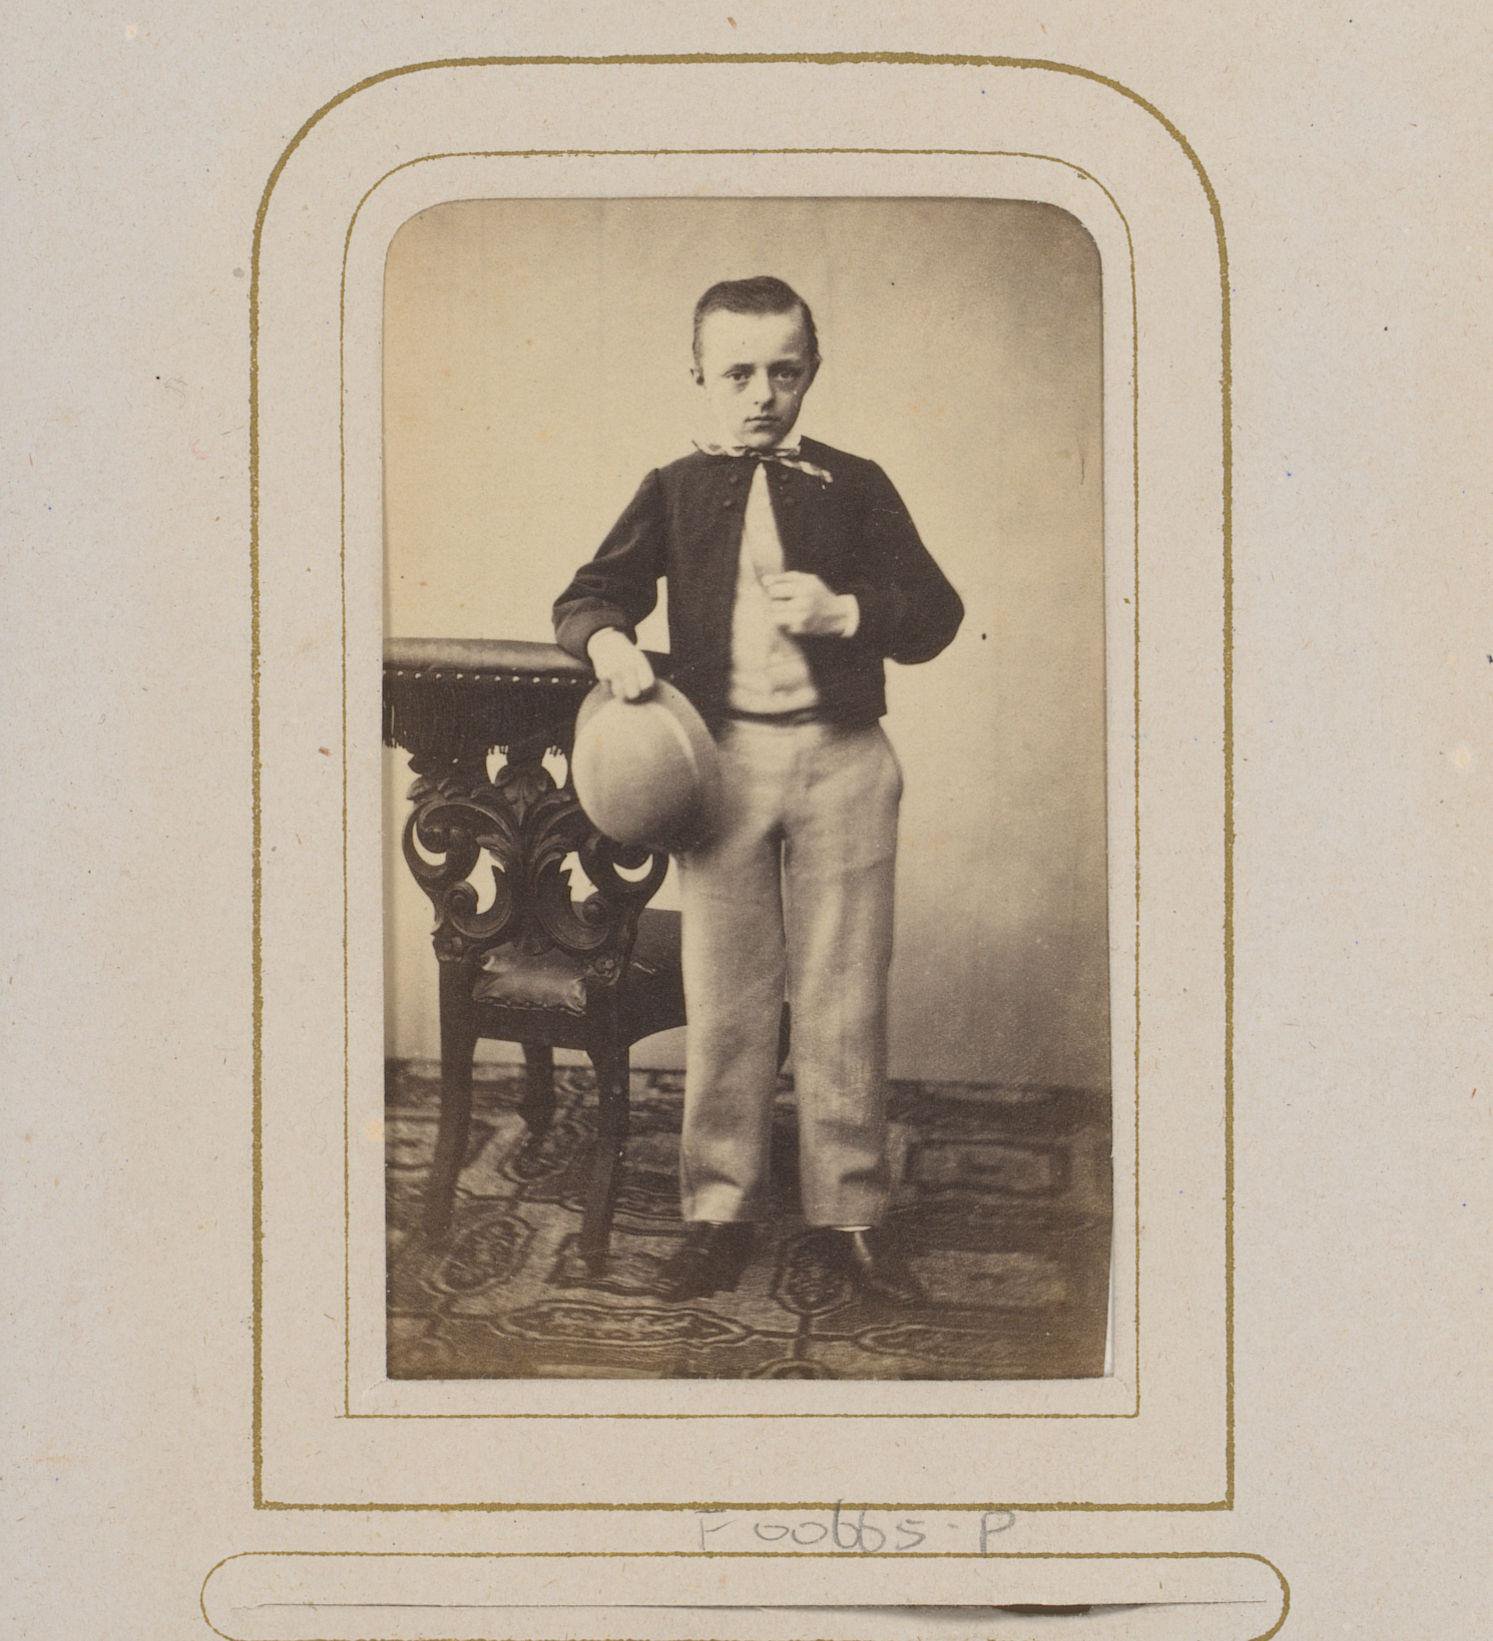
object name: photograph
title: Portret van een jongen met bolhoed in hand bij een stoel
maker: hermanus siderius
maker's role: draughtsman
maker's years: 1819-1892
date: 1855-1892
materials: cardboard, photographic support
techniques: albumen print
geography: harlingen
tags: boy (child between toddler and youth)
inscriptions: inscription: ‘H. Siderius/ Phot./ Harlingen’